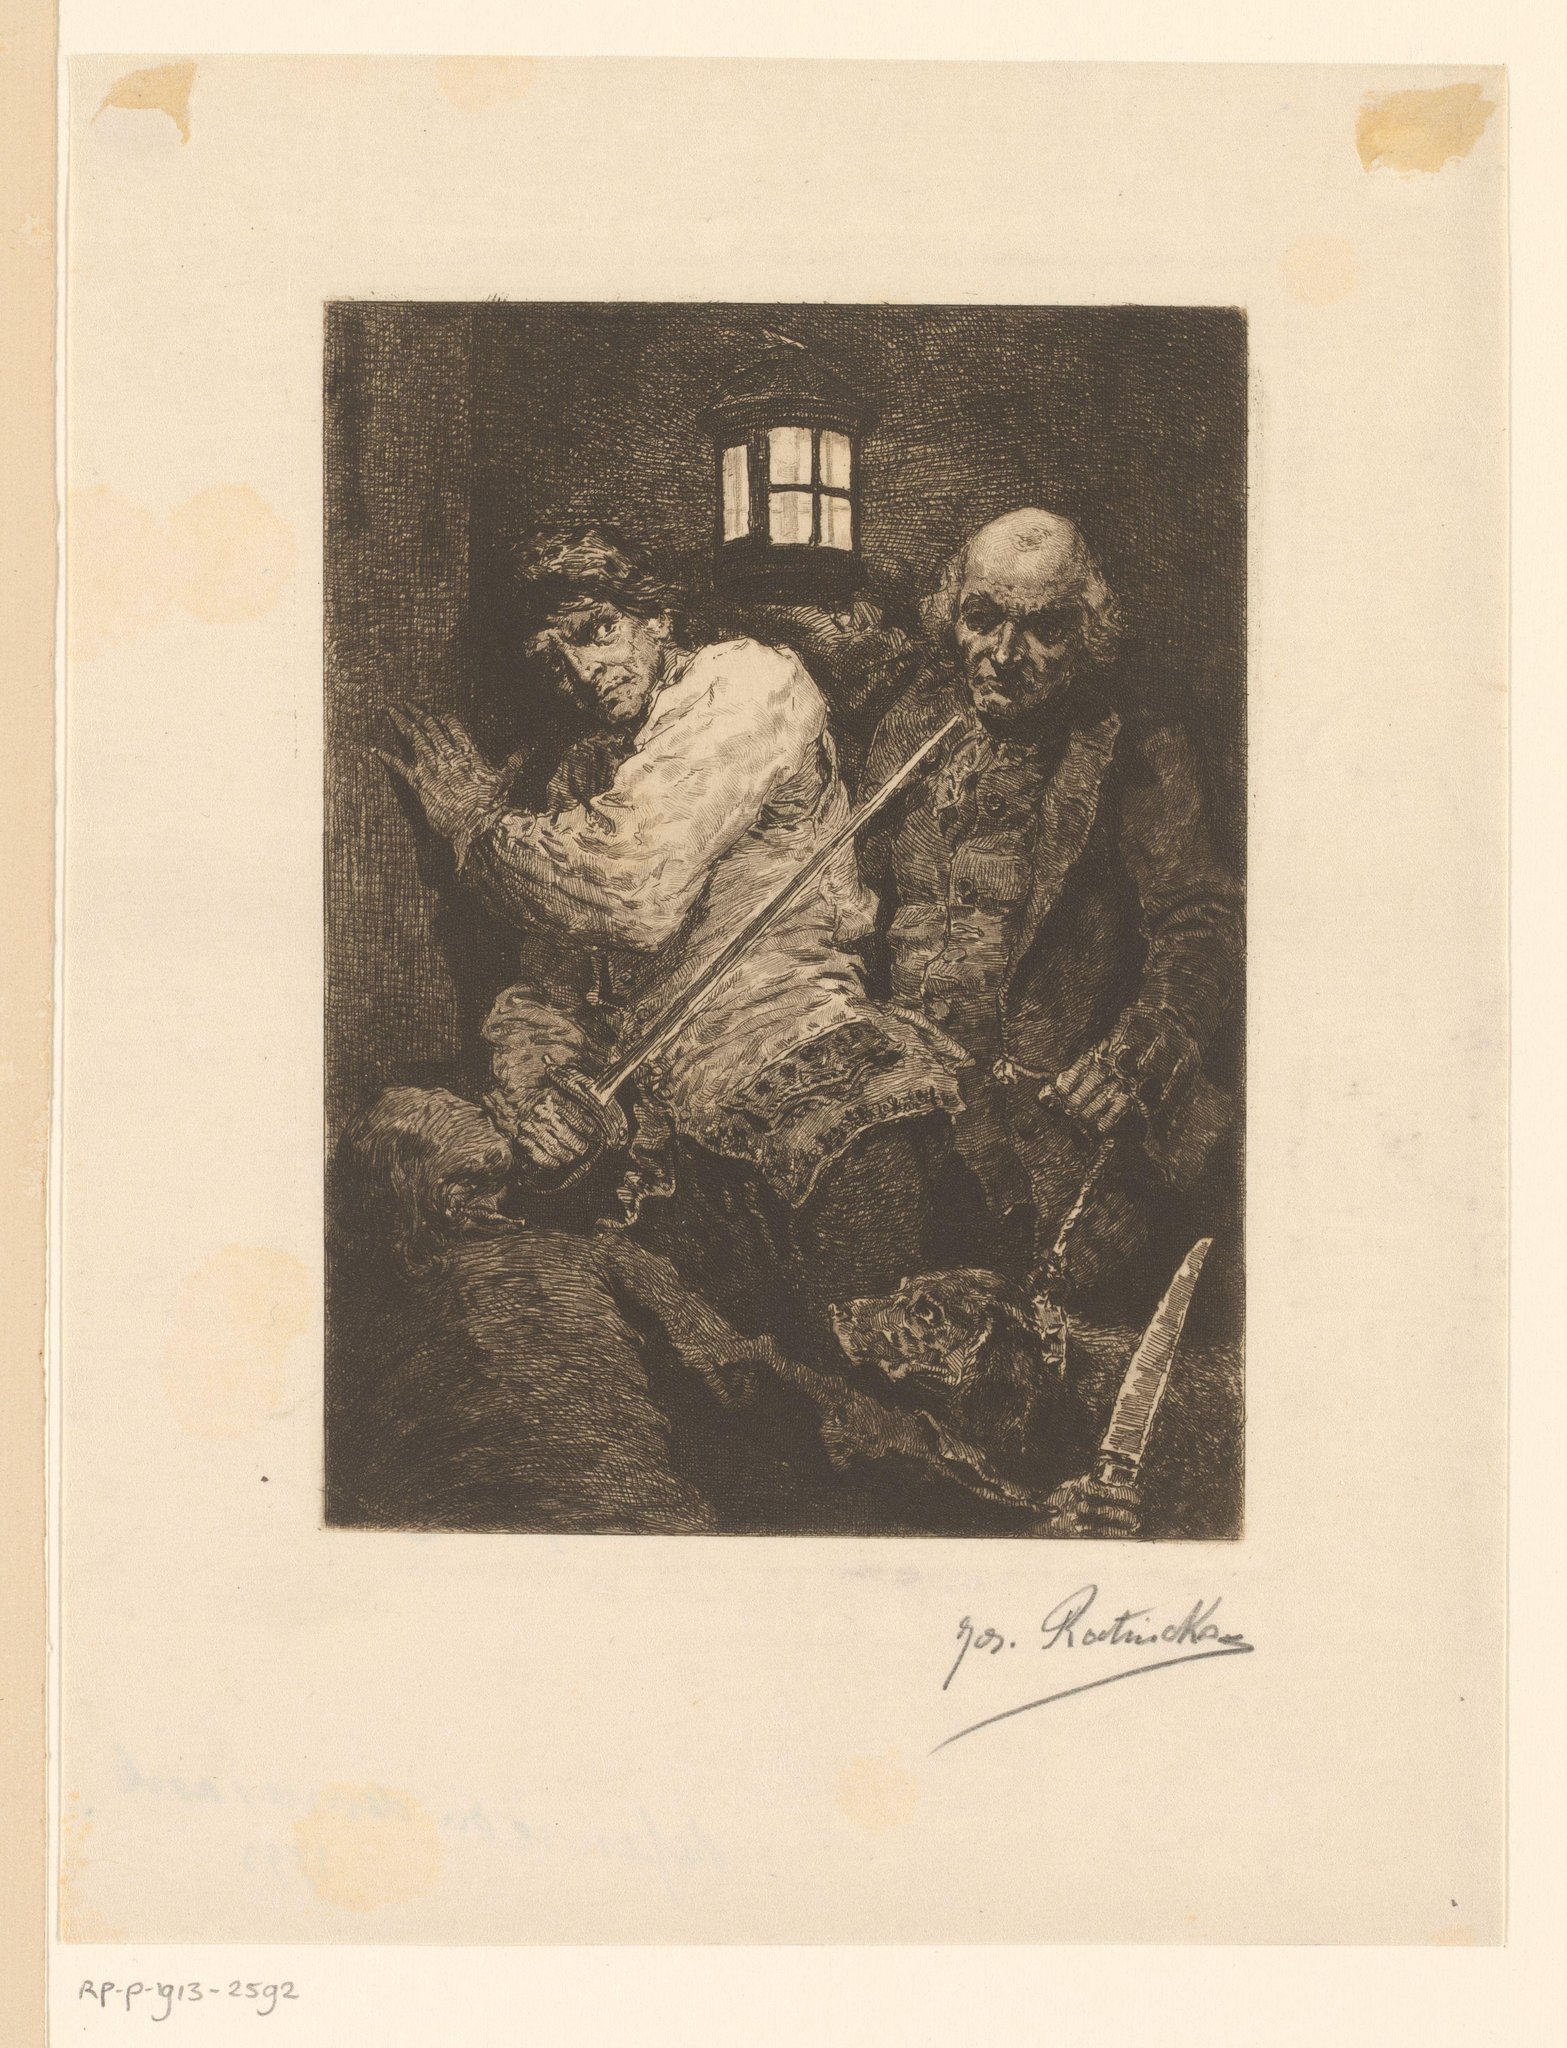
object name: print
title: Man verdedigt zichzelf met een zwaard tegenover een man met lantaarn en hond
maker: jos ratinckx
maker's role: print maker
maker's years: 1860-1937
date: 1870-1913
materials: paper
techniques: etching, retroussage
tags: hacking and thrusting weapons: sword, lantern, being attacked; defence, dog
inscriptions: mark: ‘Antwerpsche Etsers 1880’, collector's mark: Lugt 2228